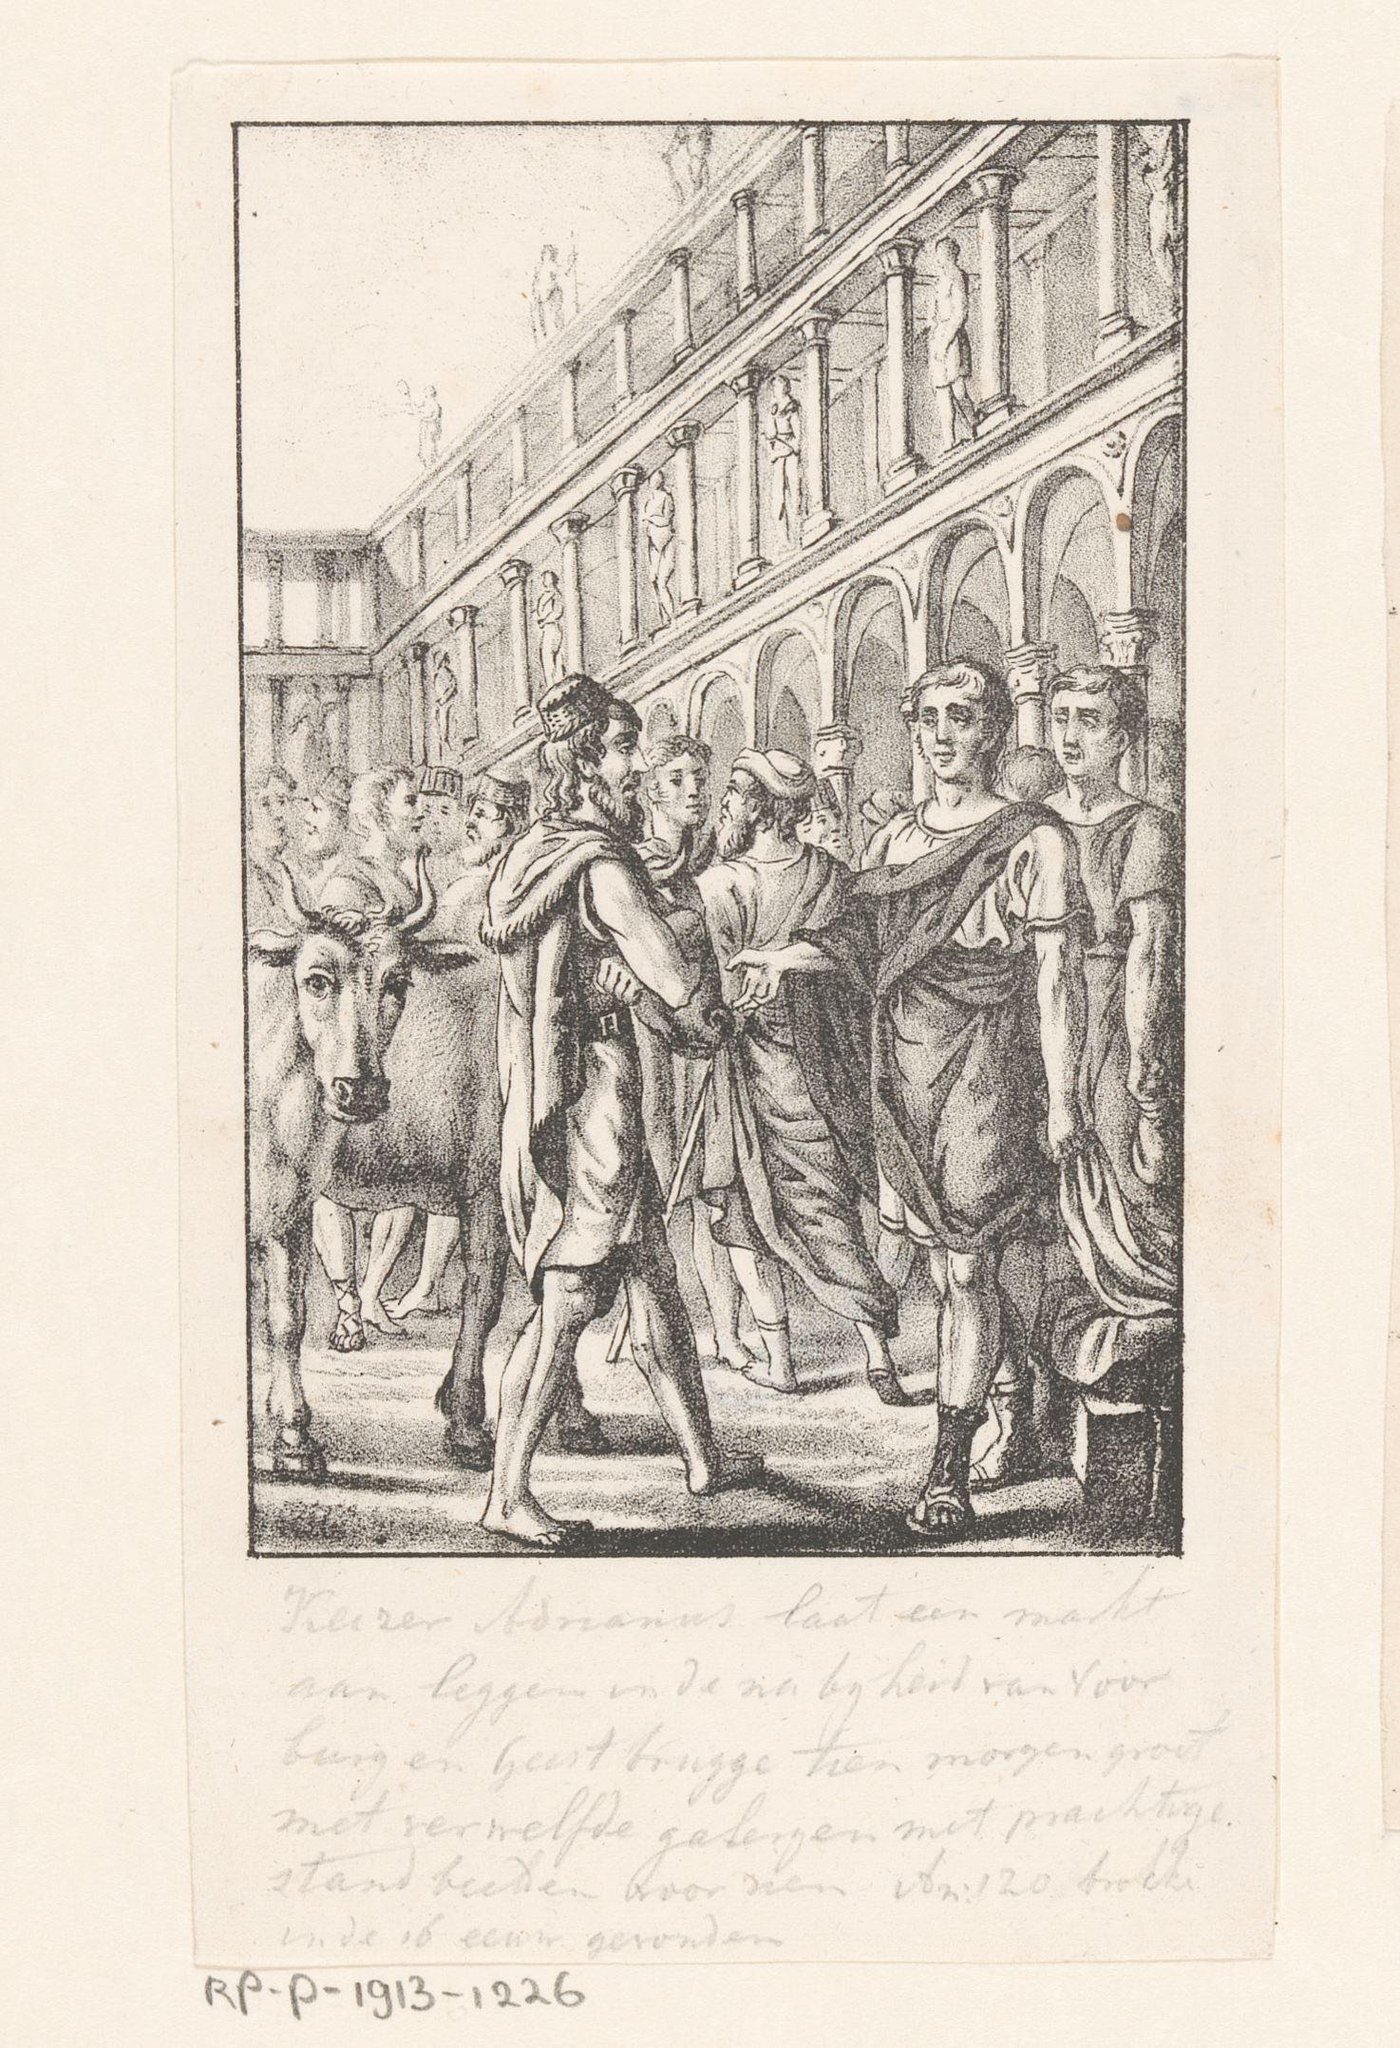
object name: print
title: Keizer Hadrianus en de markt bij Voorburg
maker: Anonymous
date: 1809-1899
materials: paper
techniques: lithograph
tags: market-hall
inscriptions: collector's mark: Lugt 2228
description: Voor de markt, voorzien van sculpturen en zuilen, staan figuren waaronder twee Romeinen. De markt kan ook verwijzen naar de zogenaamde marktrechten die Keizer Hadrianus tijdens een bezoek aan de stad ontleende.